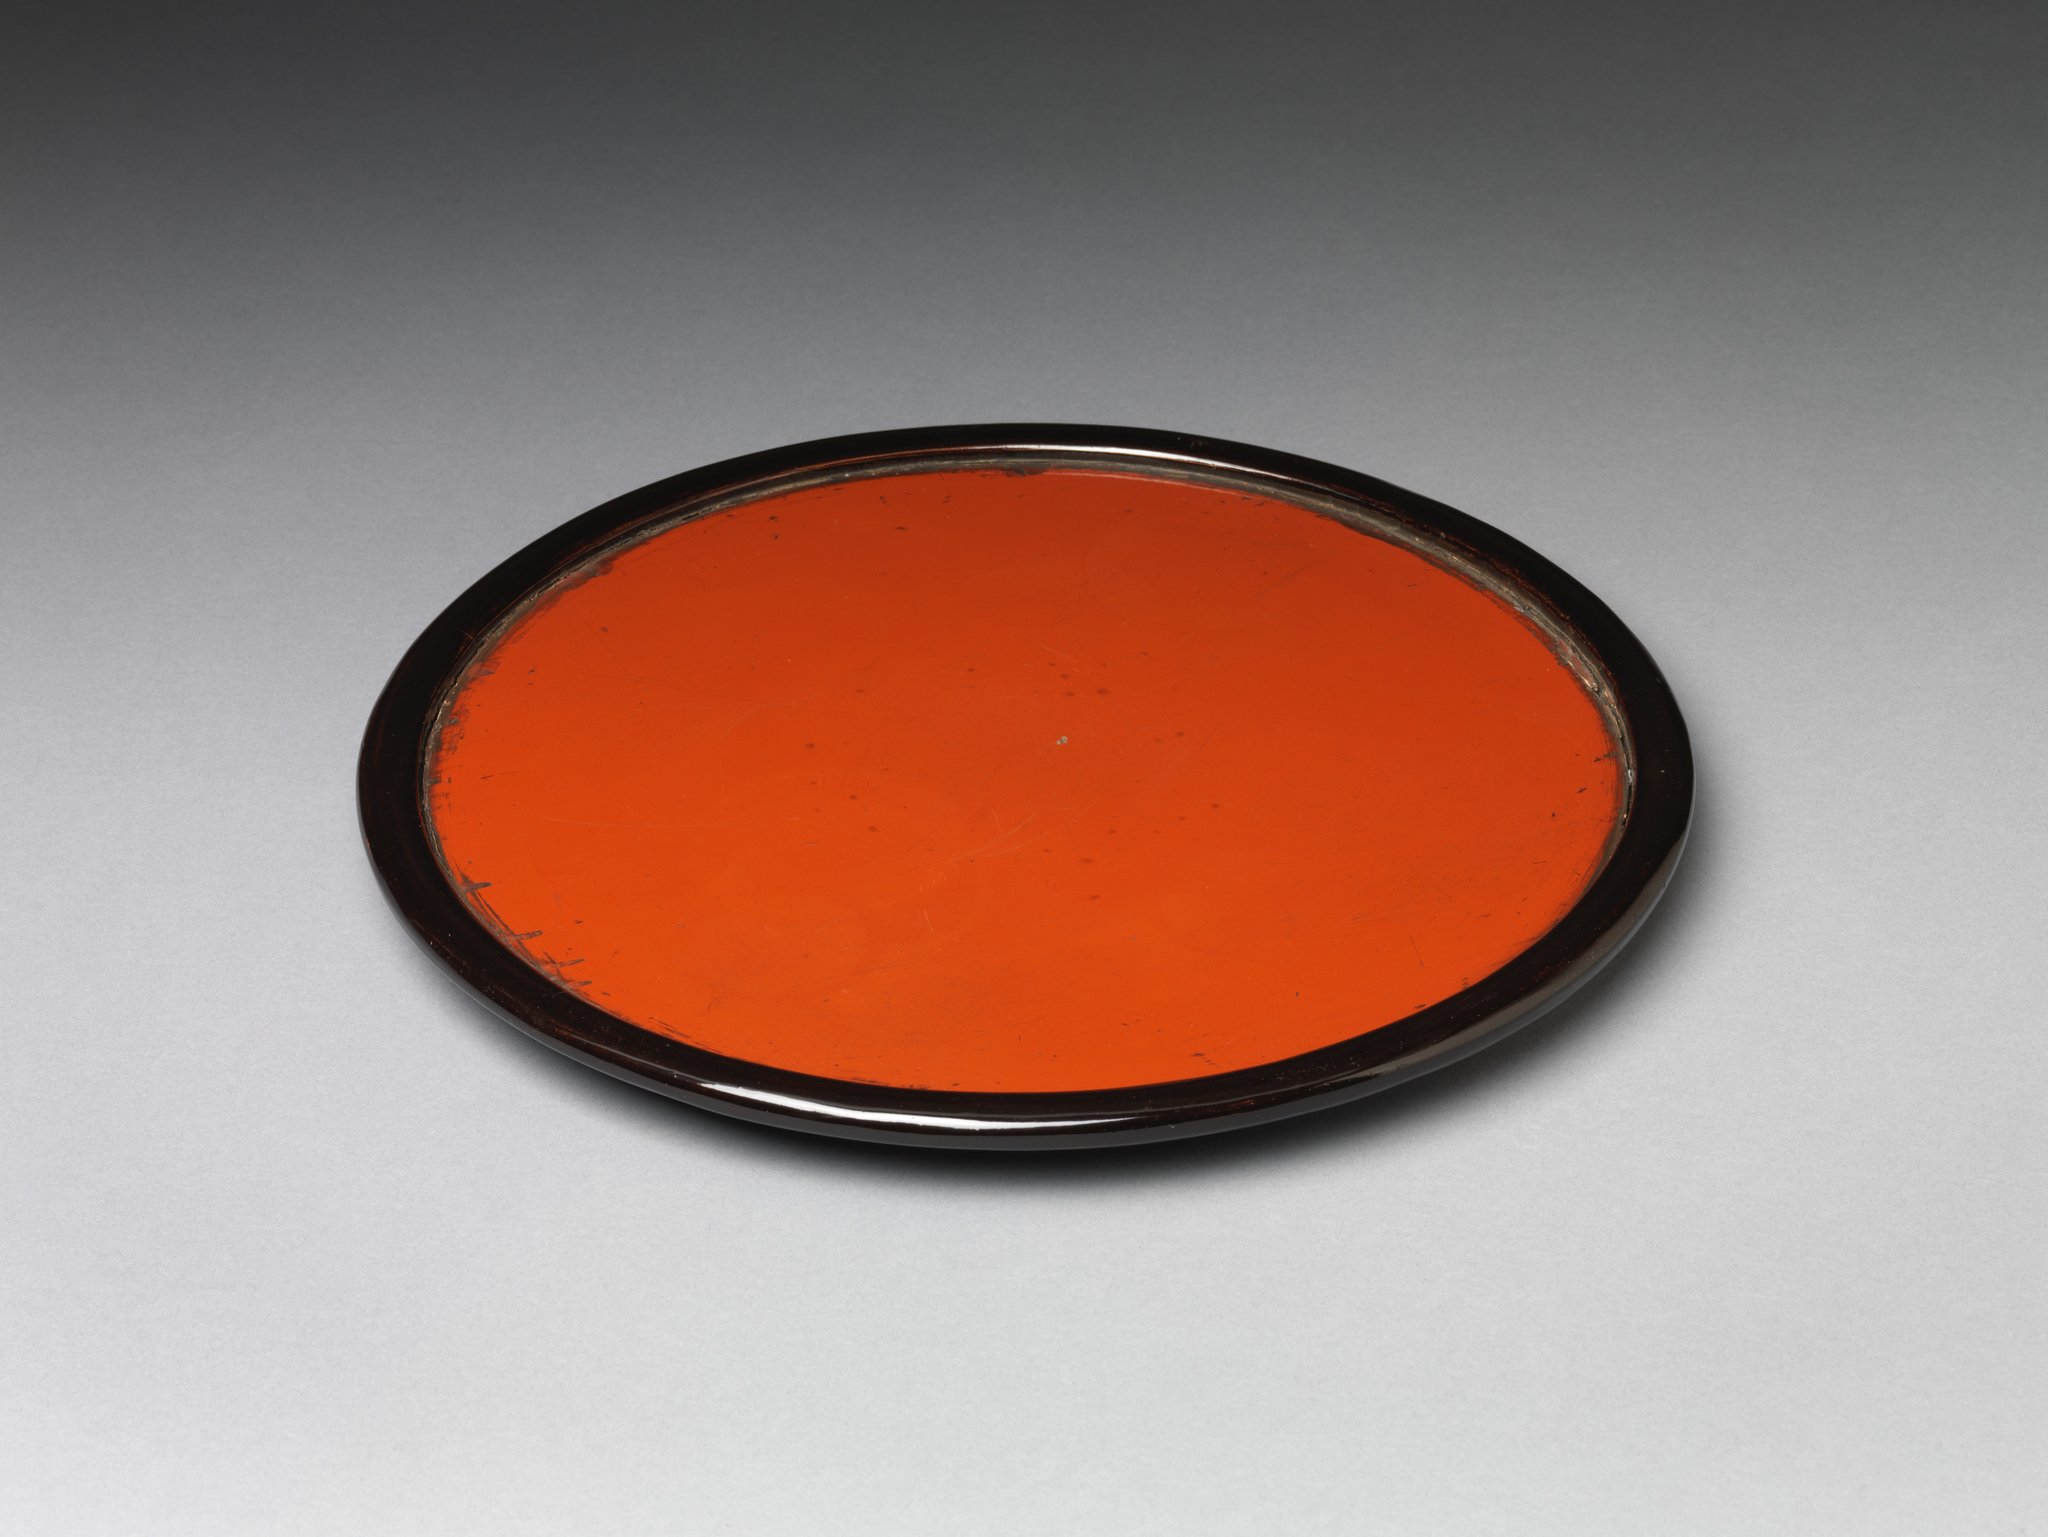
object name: tray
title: Round Tray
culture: japanese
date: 1615-1868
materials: lacquer